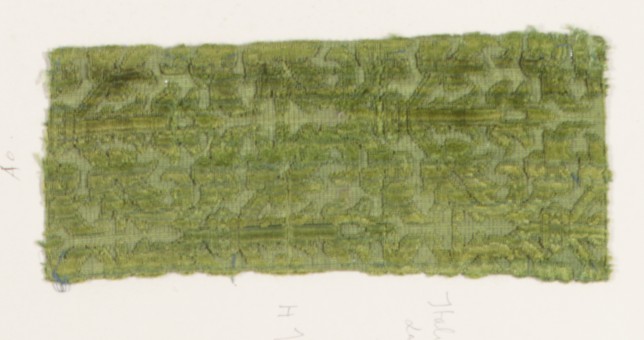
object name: fragment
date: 1501-1600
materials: silk